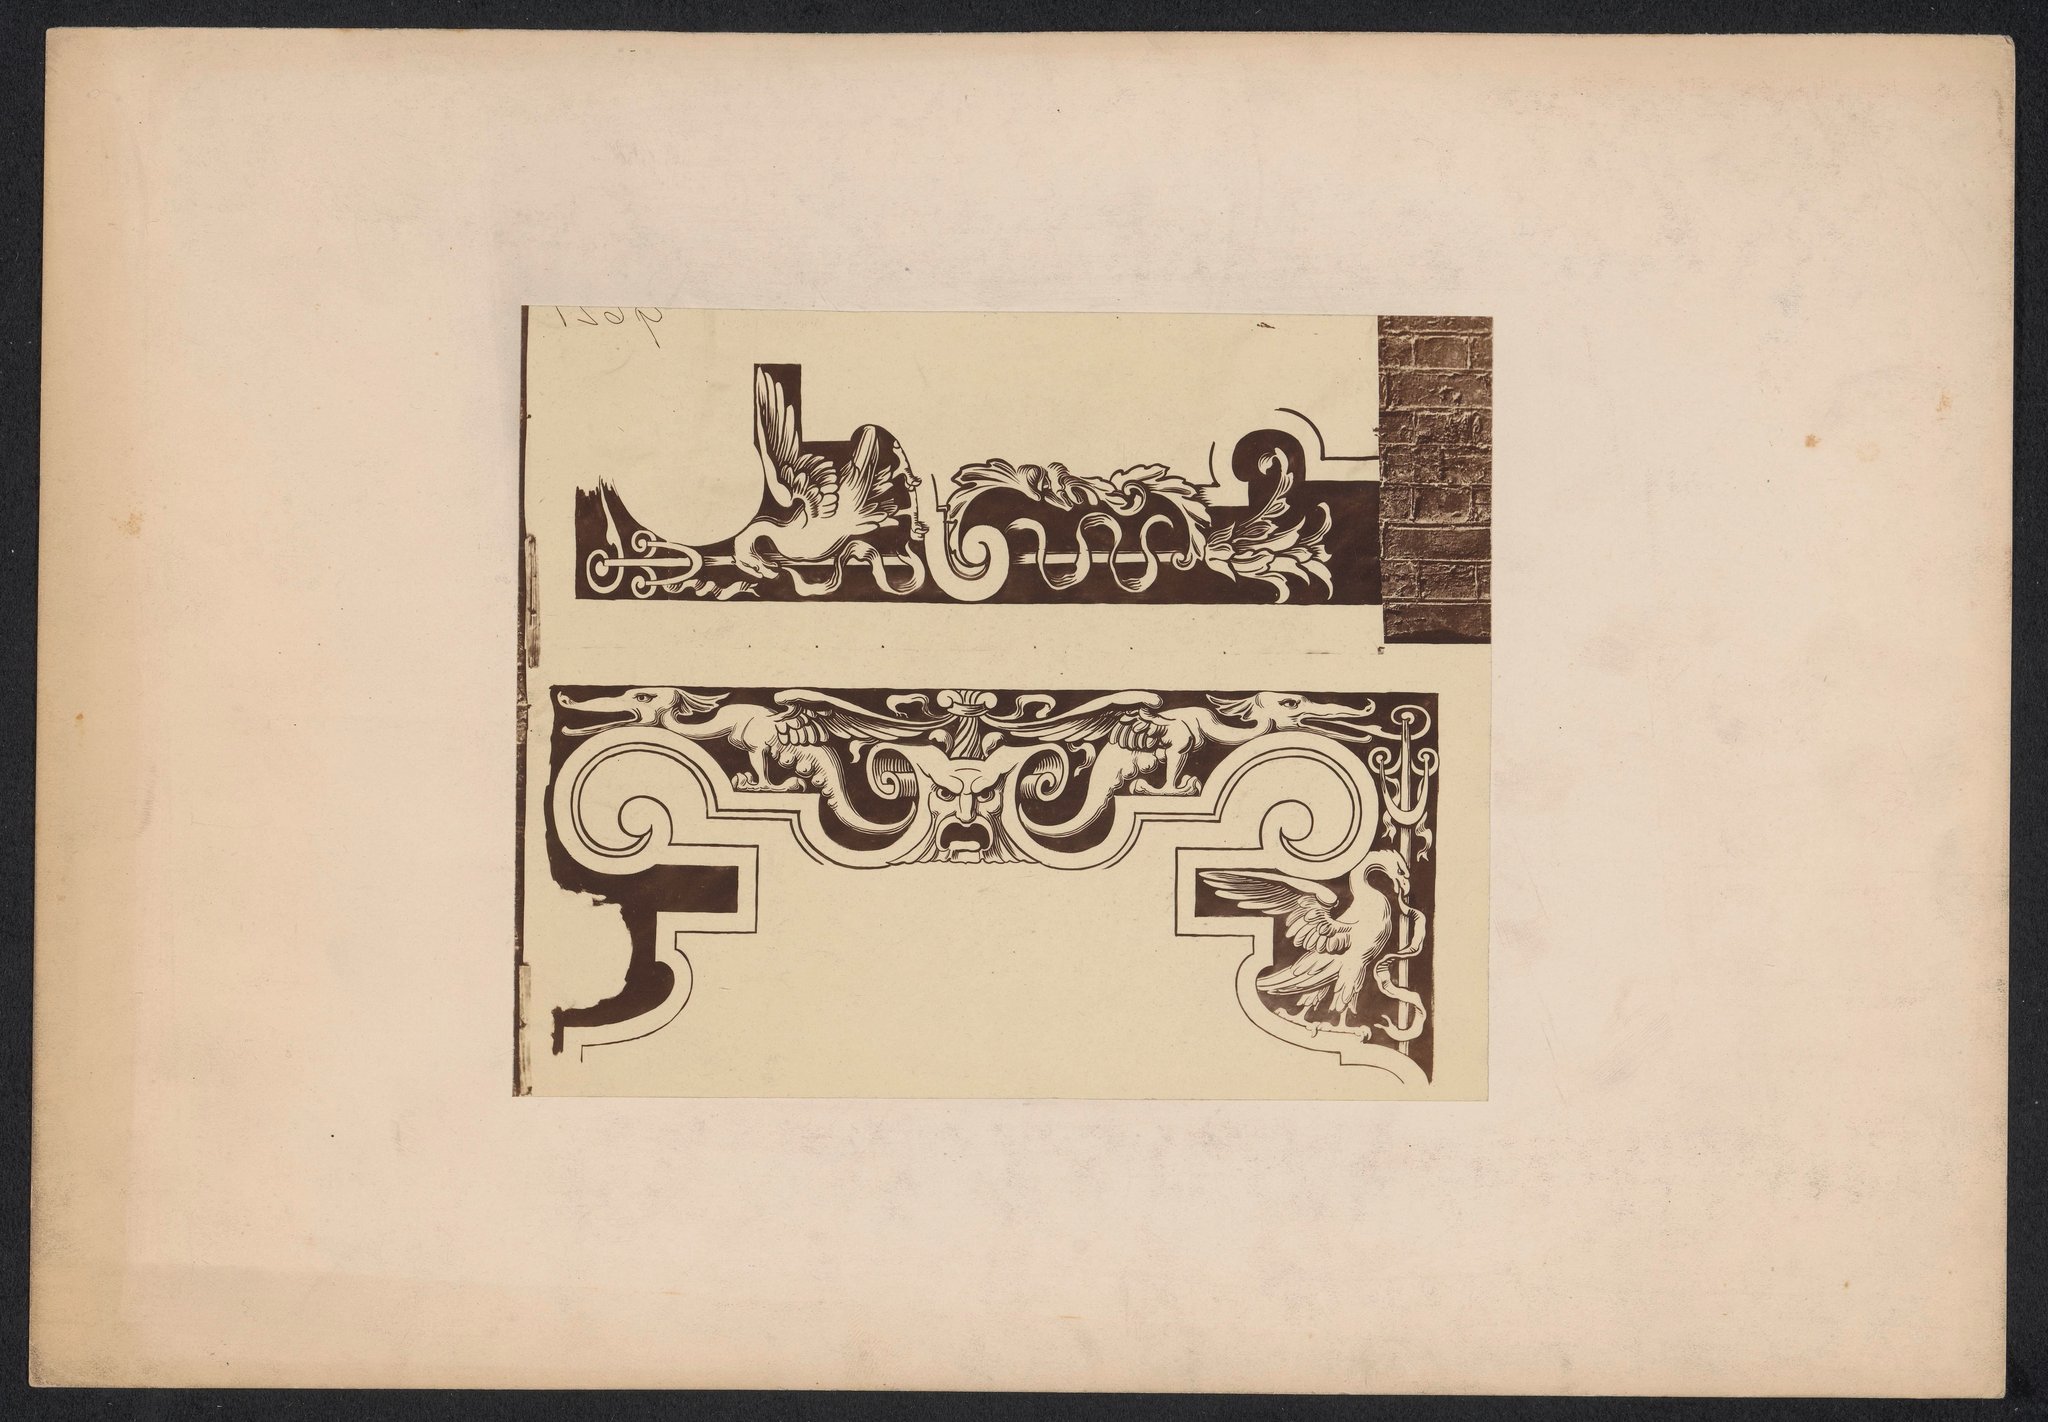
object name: photomontage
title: Twee ornamentprenten met vogels en fantasiewezens op een muur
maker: Anonymous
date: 1875-1900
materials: cardboard, photographic support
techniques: albumen print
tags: ornament ~ hybrid animals, ornamental birds, other fantasy ornament, mask, mascaron ~ ornament, ornament derived from architectural details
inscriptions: number: ‘7621’, collector's mark: Lugt 3937